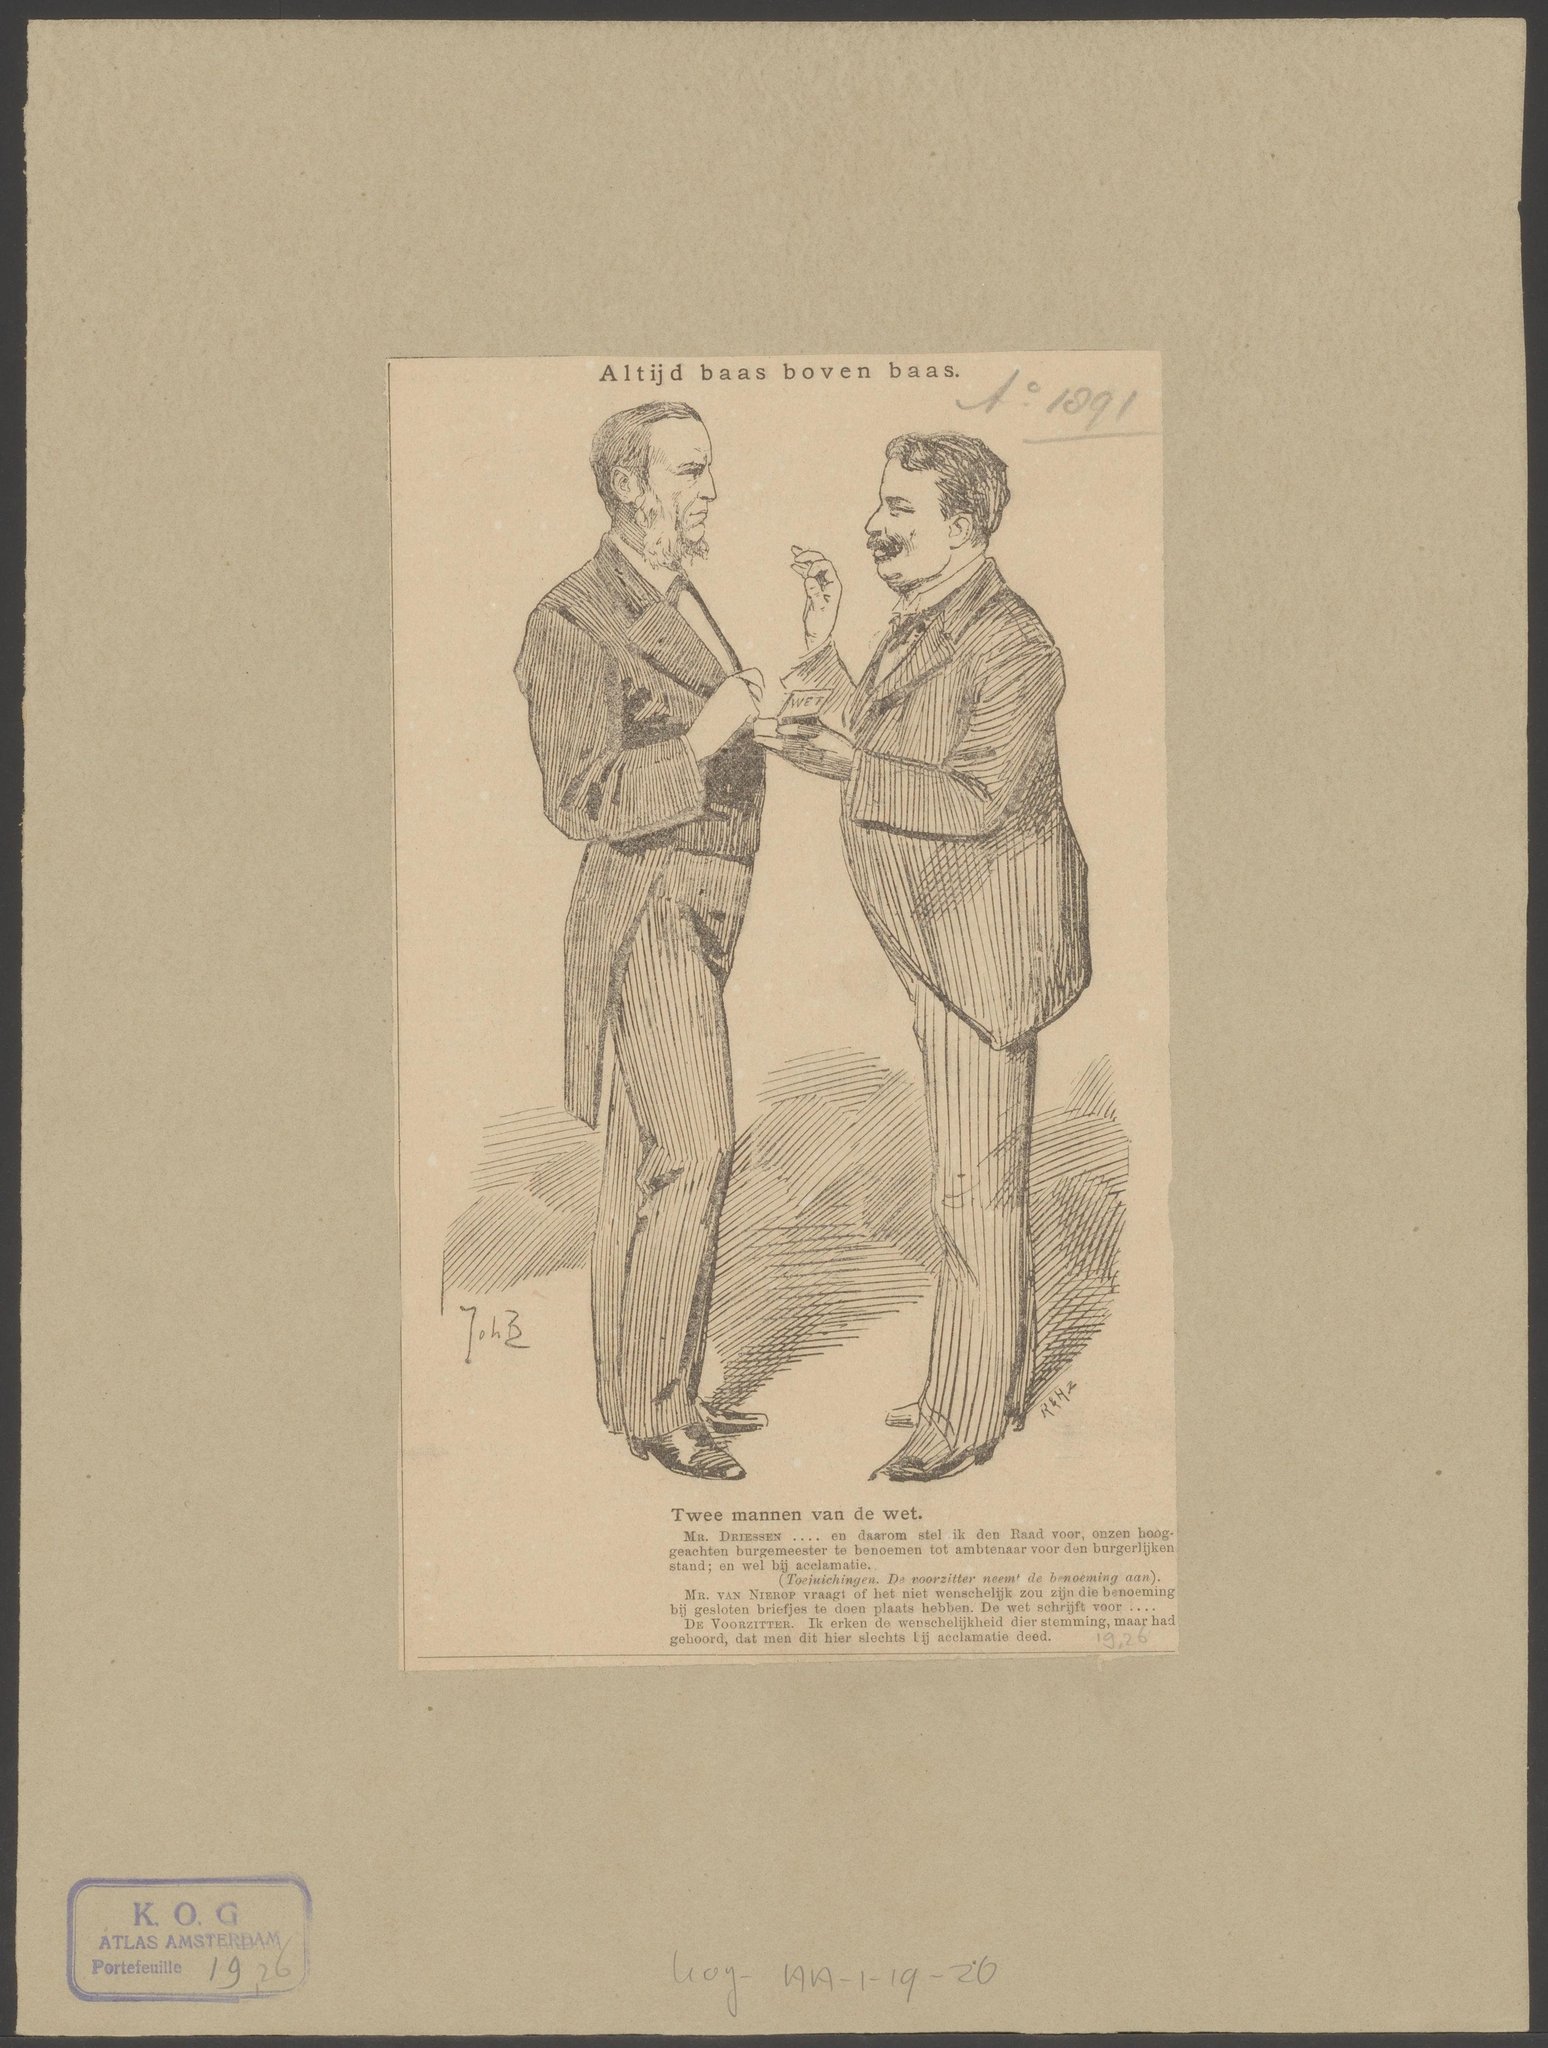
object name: cartoon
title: Altijd baas boven baas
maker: johan braakensiek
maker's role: draughtsman, print maker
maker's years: 1858-1940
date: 1870-1878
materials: paper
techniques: letterpress printing, line block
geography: amsterdam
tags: city council, amsterdam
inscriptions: collector's mark: ‘19,26’ Lugt 1641b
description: Onderwerpsrubriek binnen de Atlas Amsterdam: Herinneringen aan regeringsleden en hunne huisgezinnen [na 1800].